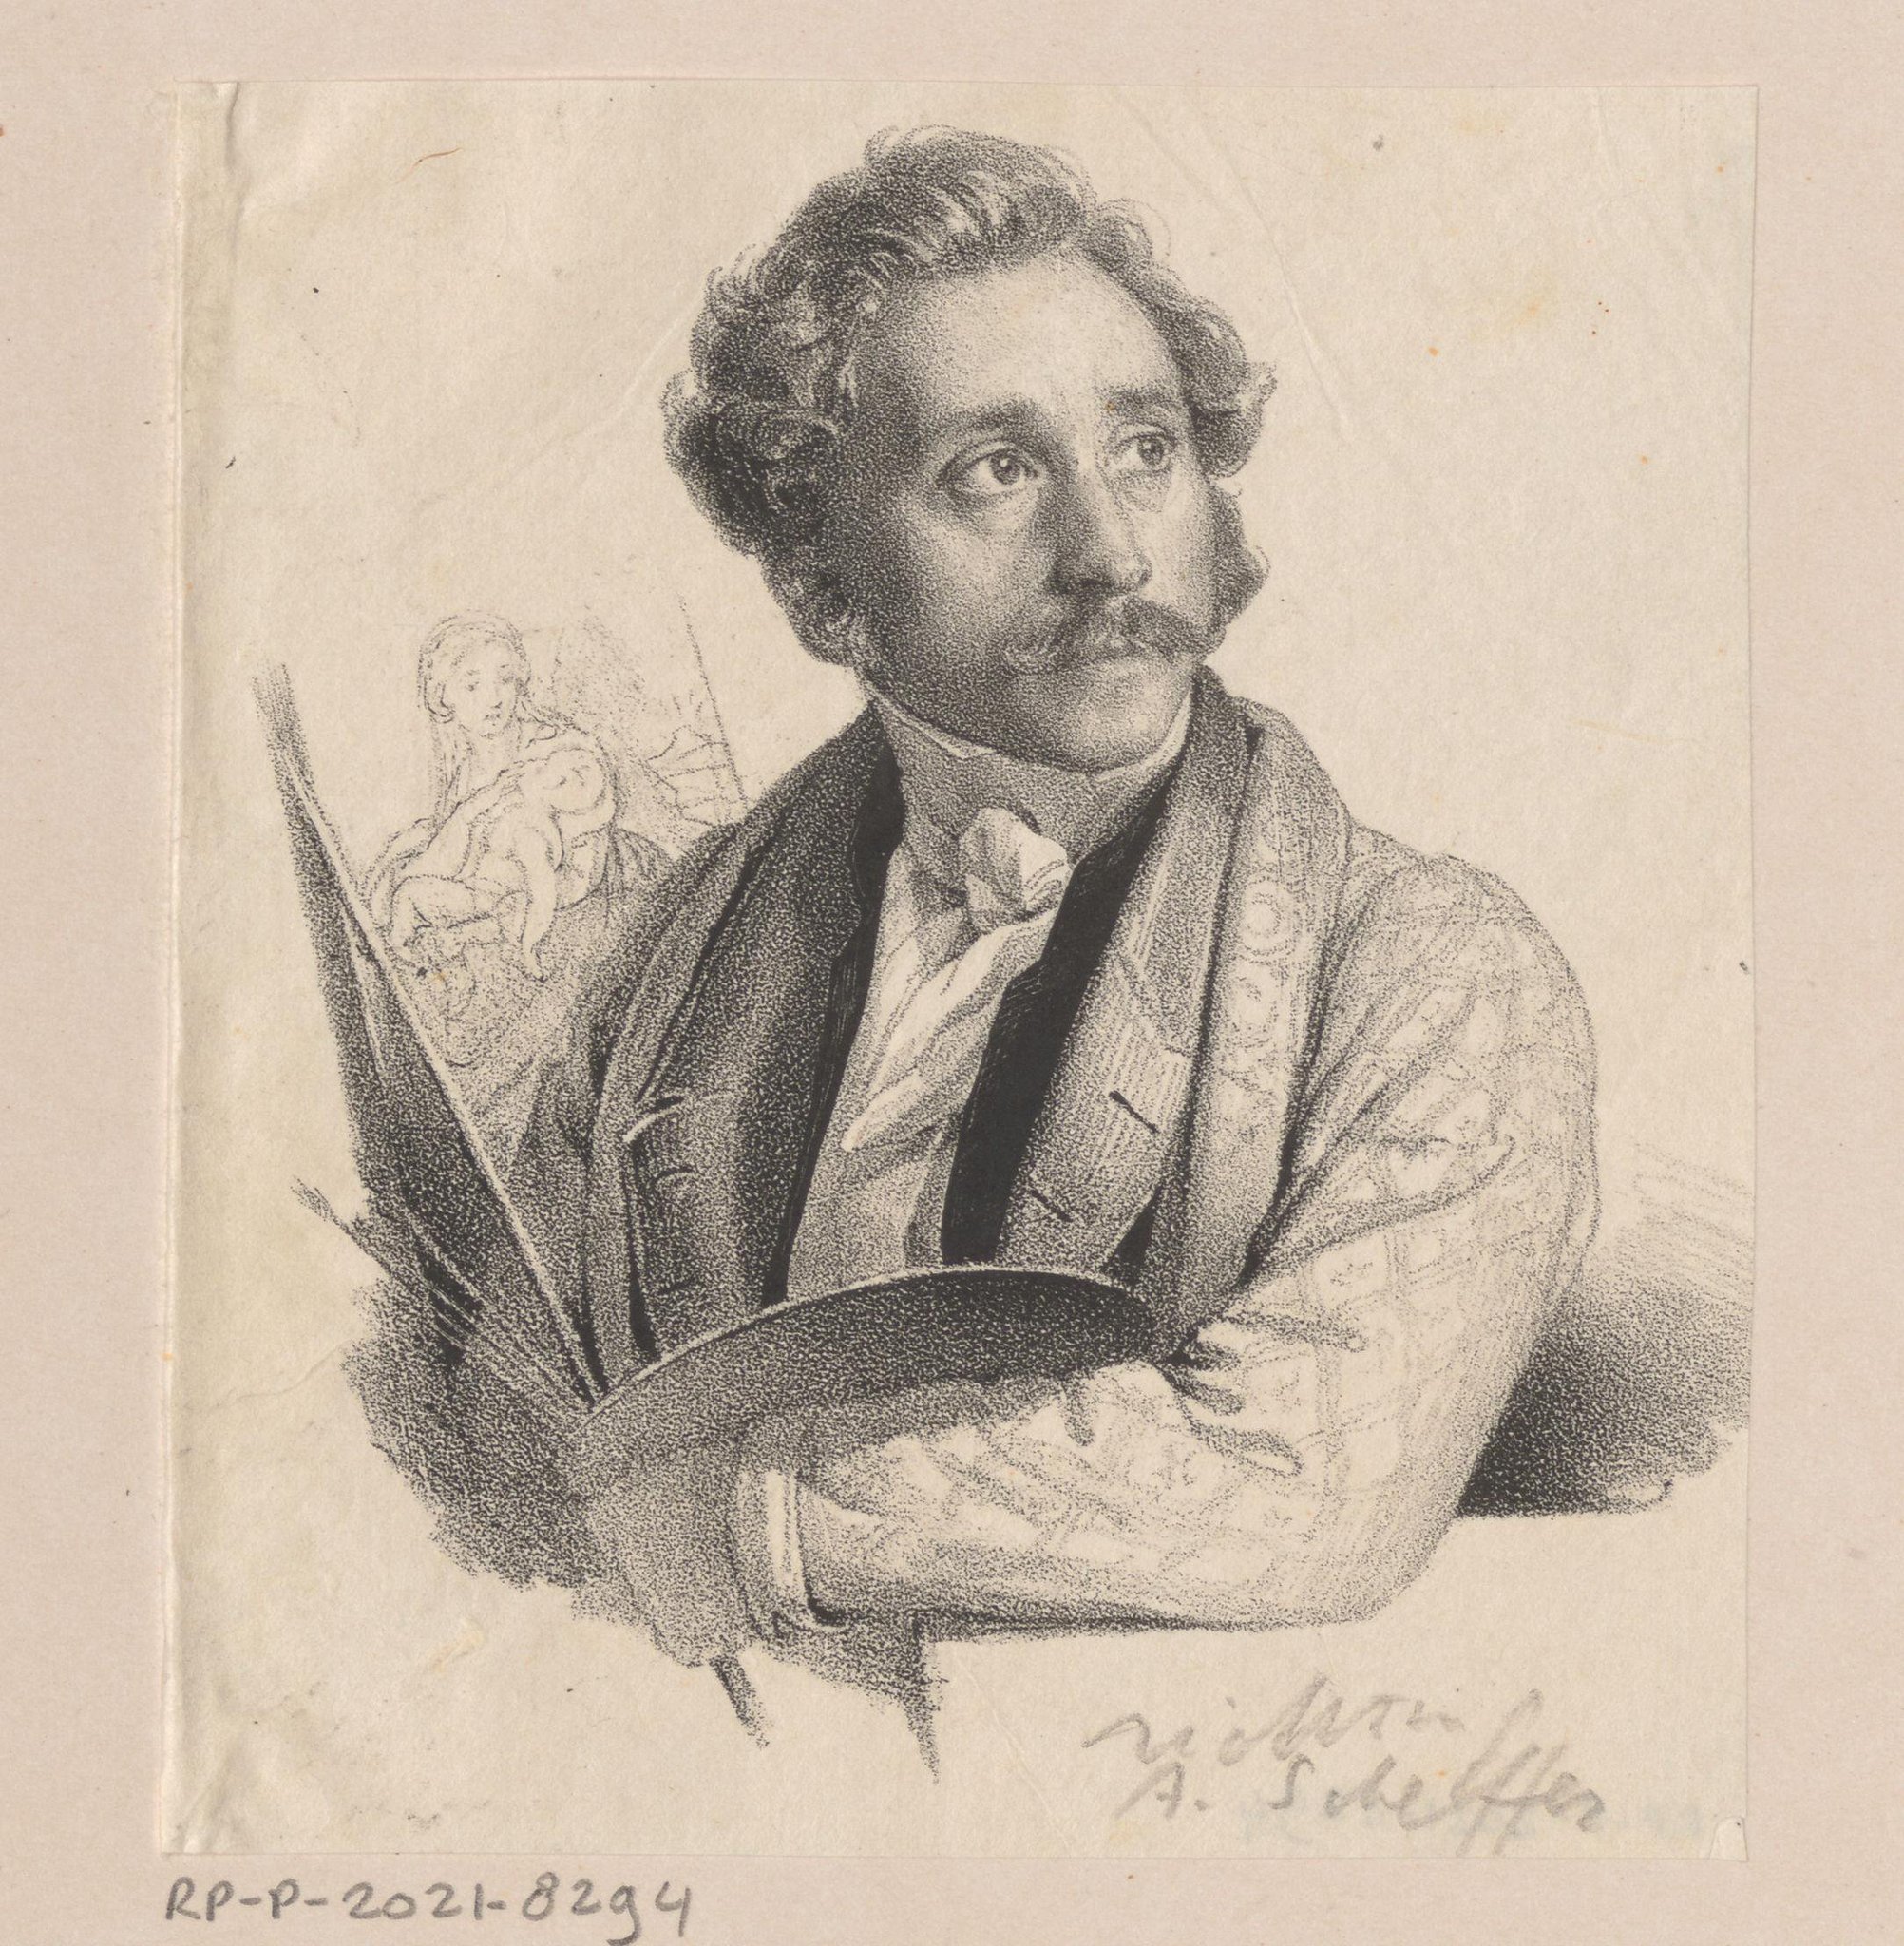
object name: print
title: Portret van Ary Scheffer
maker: Anonymous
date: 1811-1899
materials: paper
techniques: lithograph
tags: dordrecht, painter, print maker, draughtsman, sculptor, ary scheffer, historical persons, portrait, self-portrait of painter, tools, implements of painter